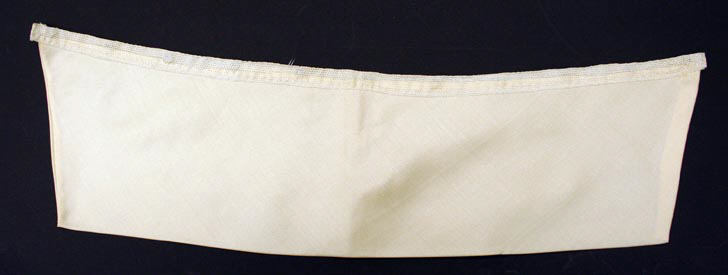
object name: collar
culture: american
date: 1700-1943